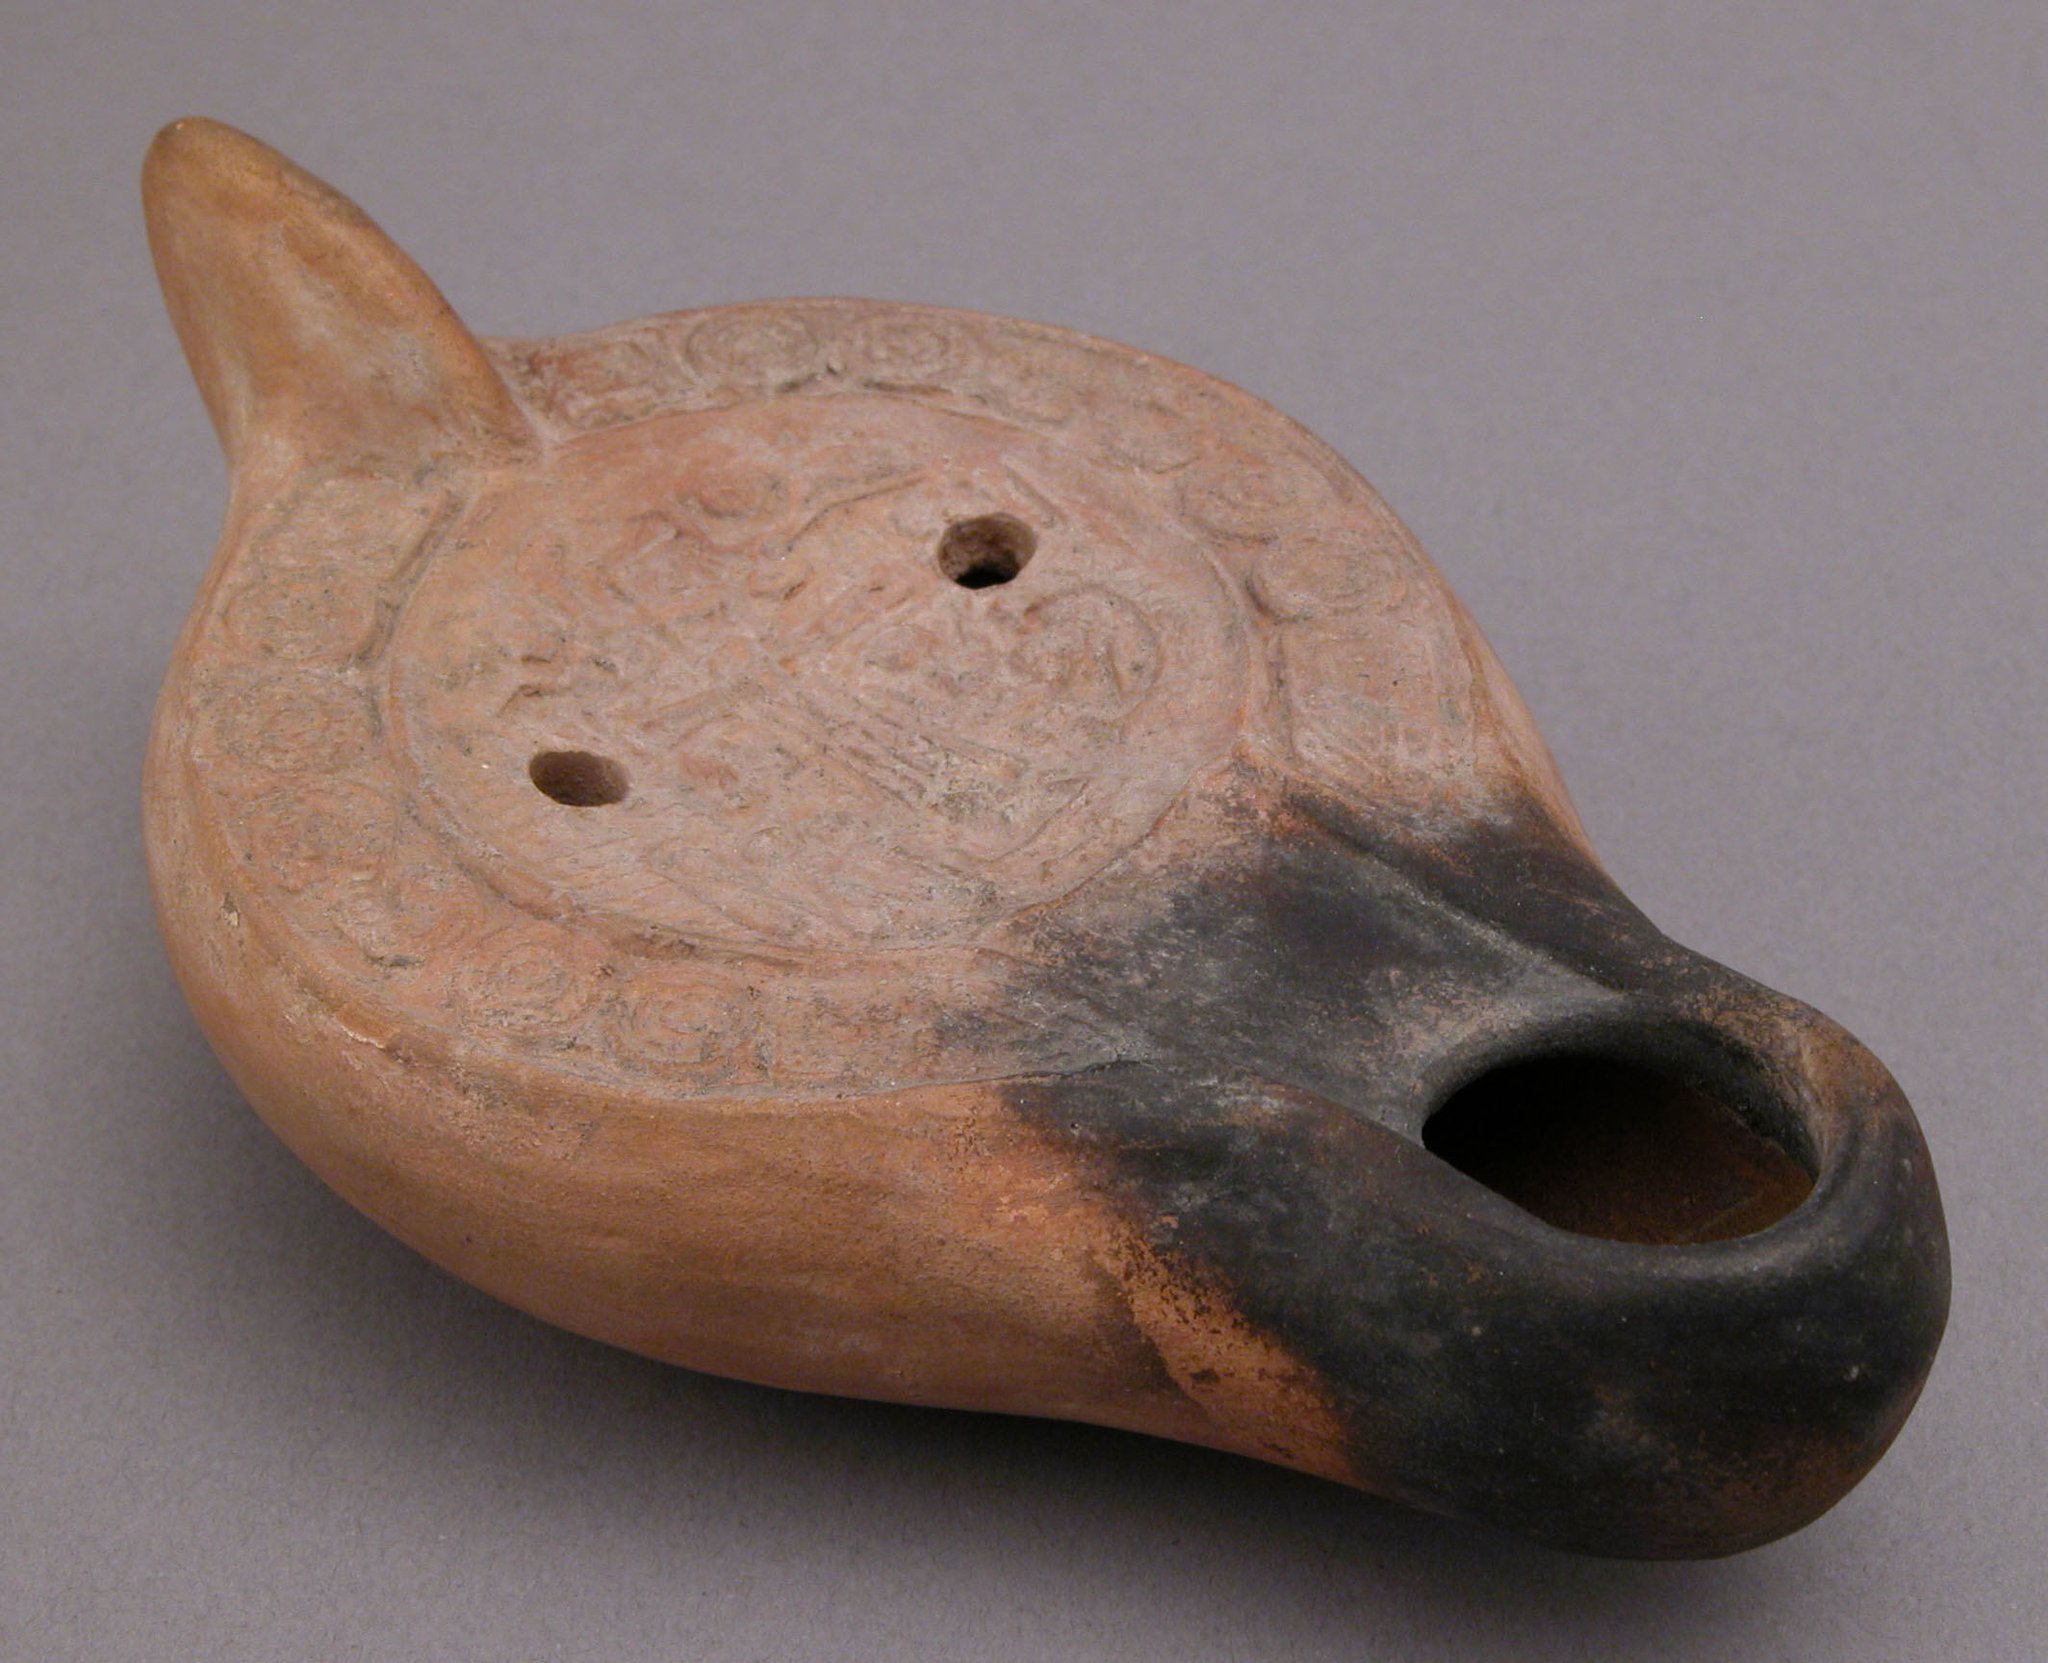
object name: lamp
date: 401-600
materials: earthenware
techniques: molding